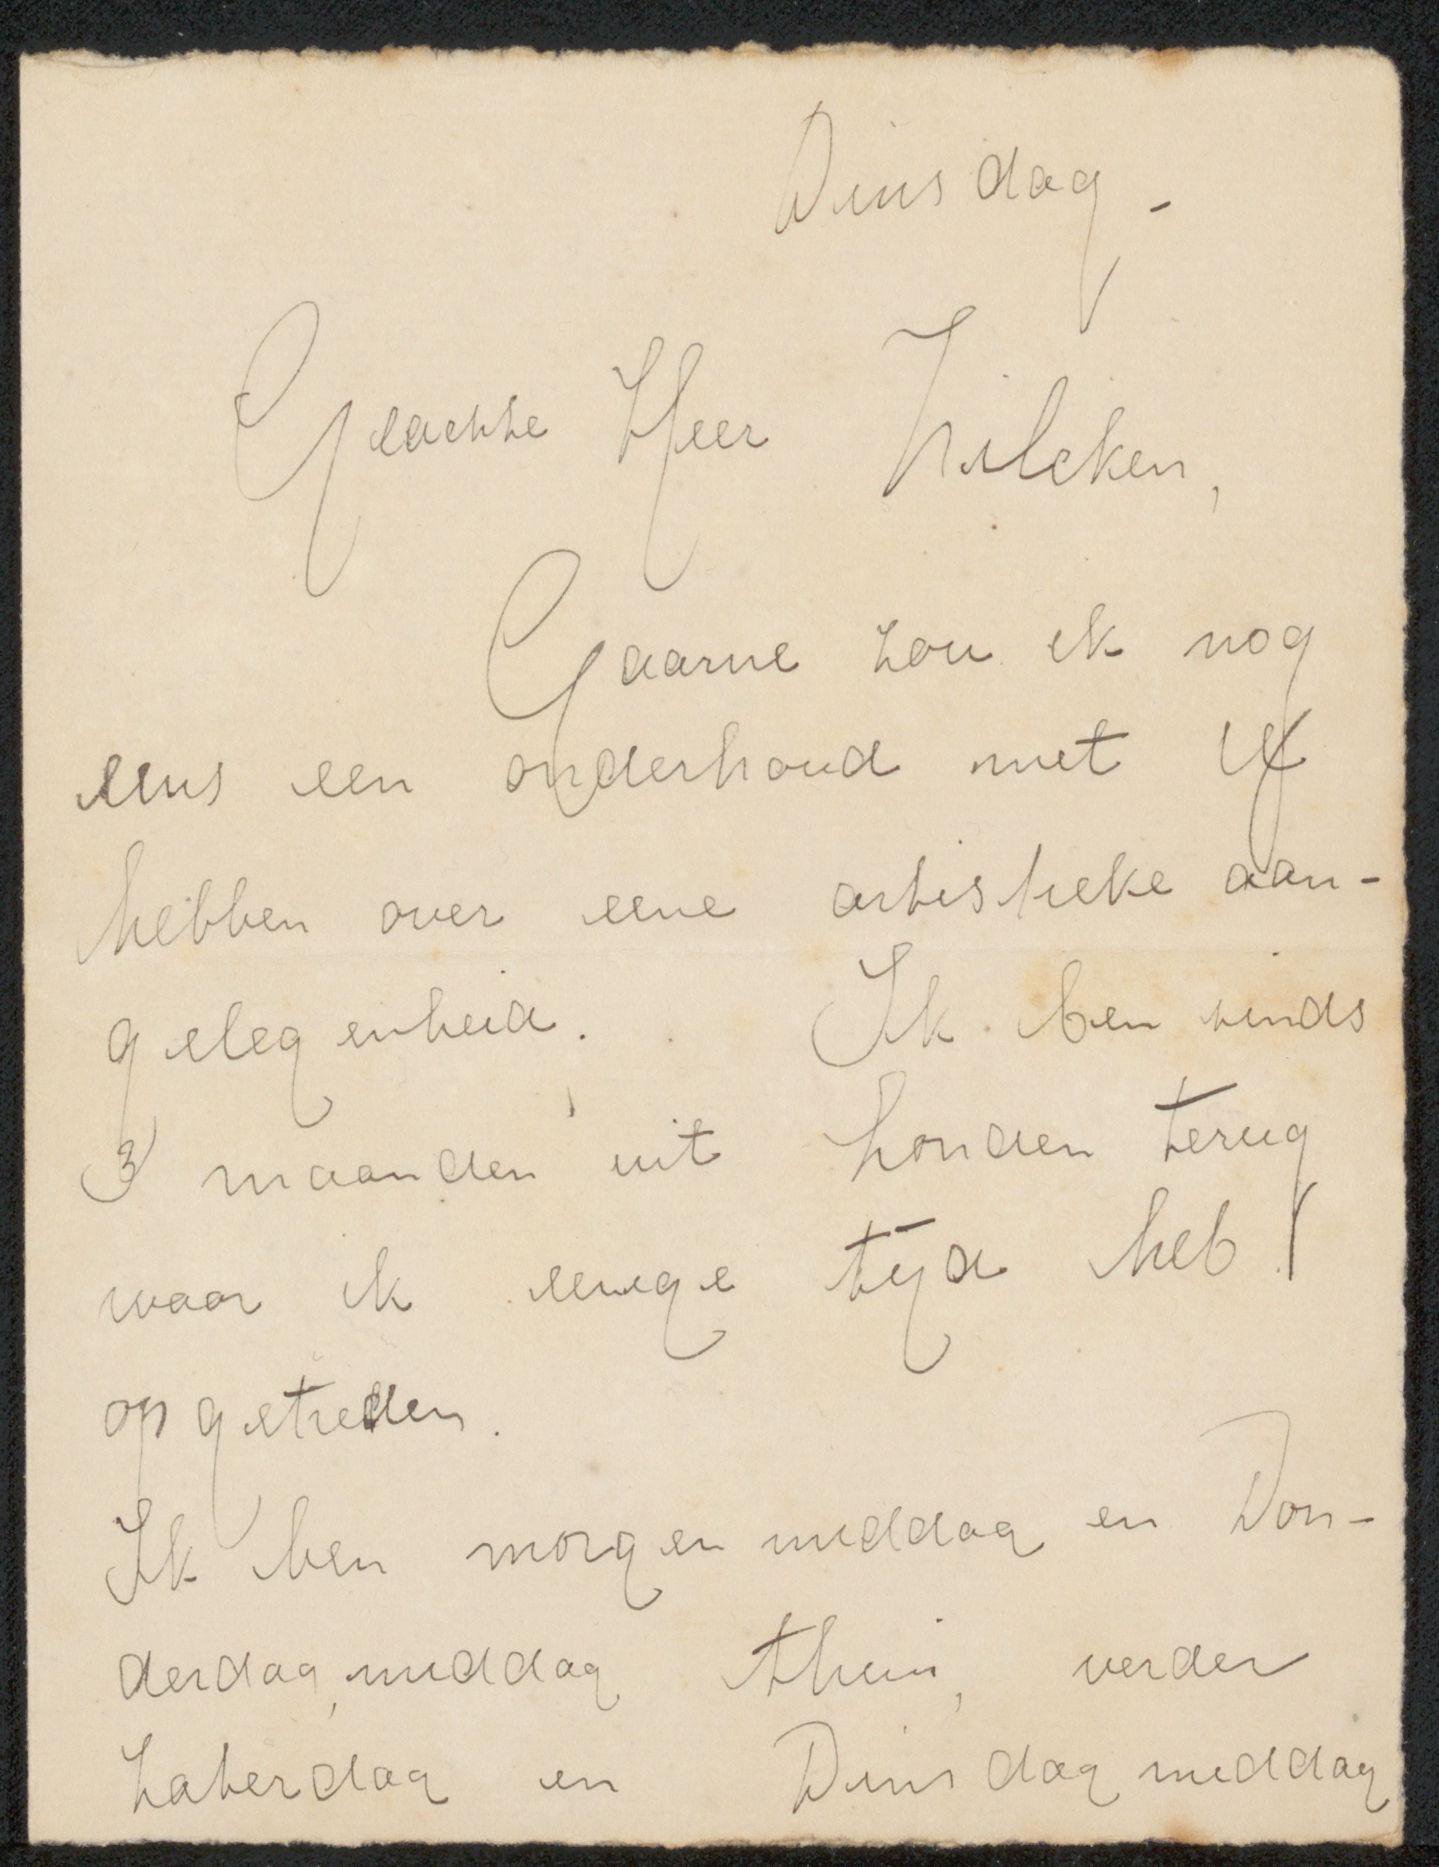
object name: letter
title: Brief aan Philip Zilcken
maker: lydia lyta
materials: ink, paper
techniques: pen, writing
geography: the hague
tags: painter, draughtsman, philip zilcken, london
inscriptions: watermark, collector's mark: ‘RPK’